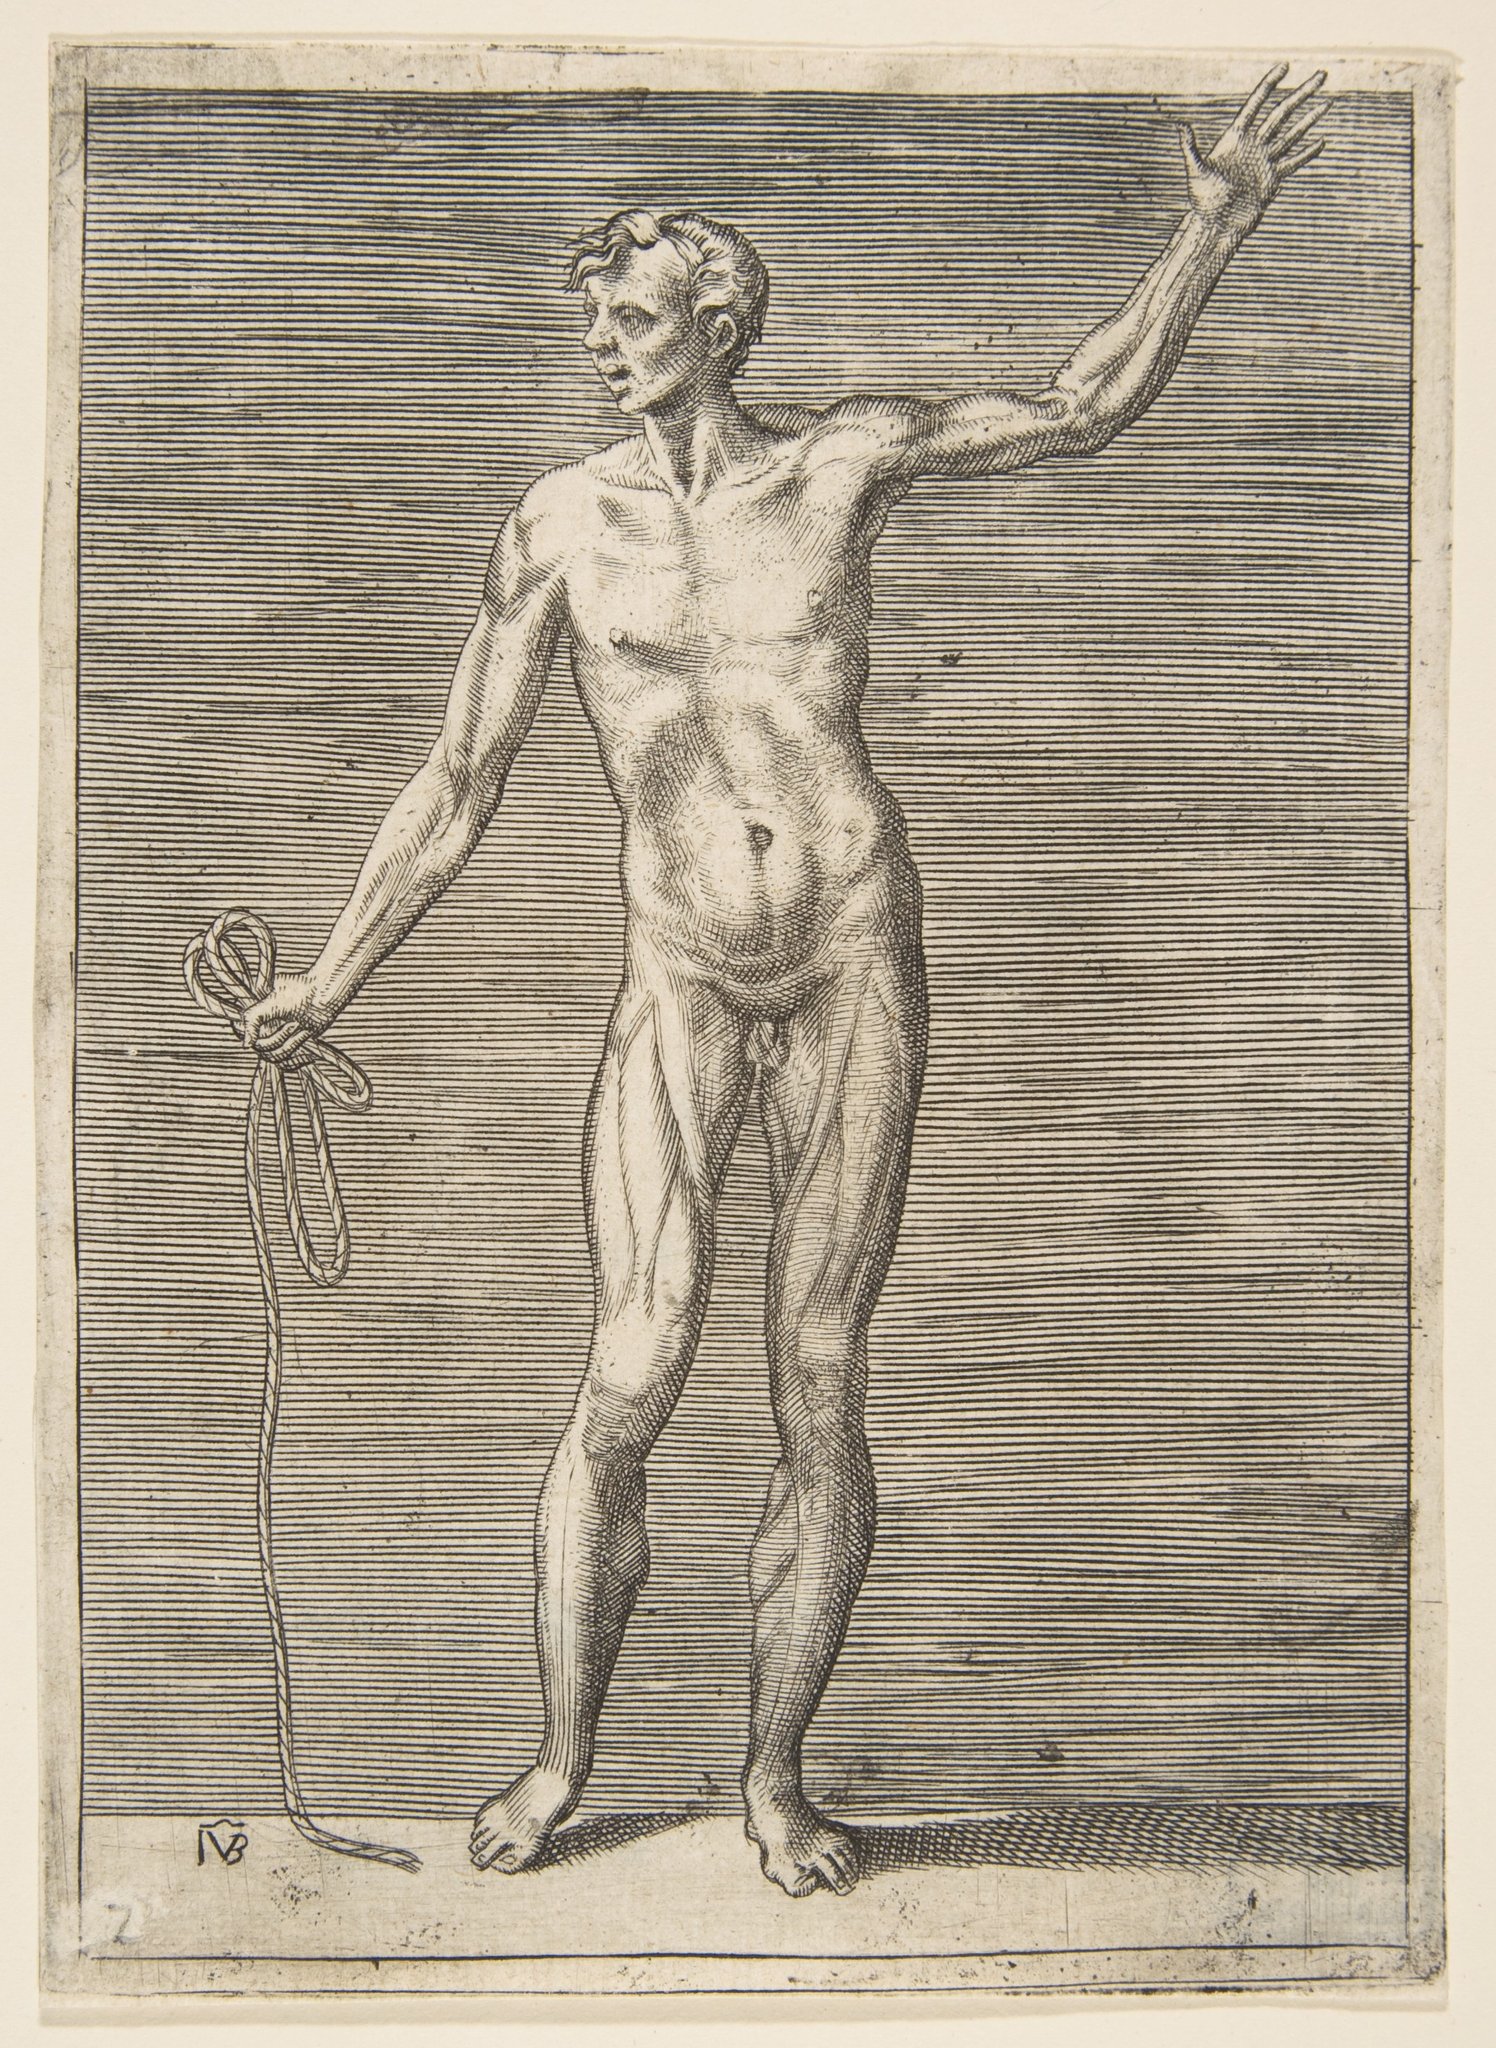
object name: print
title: Man seen from the Front, holding a Rope in his right Hand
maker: giulio bonasone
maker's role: artist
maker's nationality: italian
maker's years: 1510-1576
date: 1501-1600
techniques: engraving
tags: male nudes